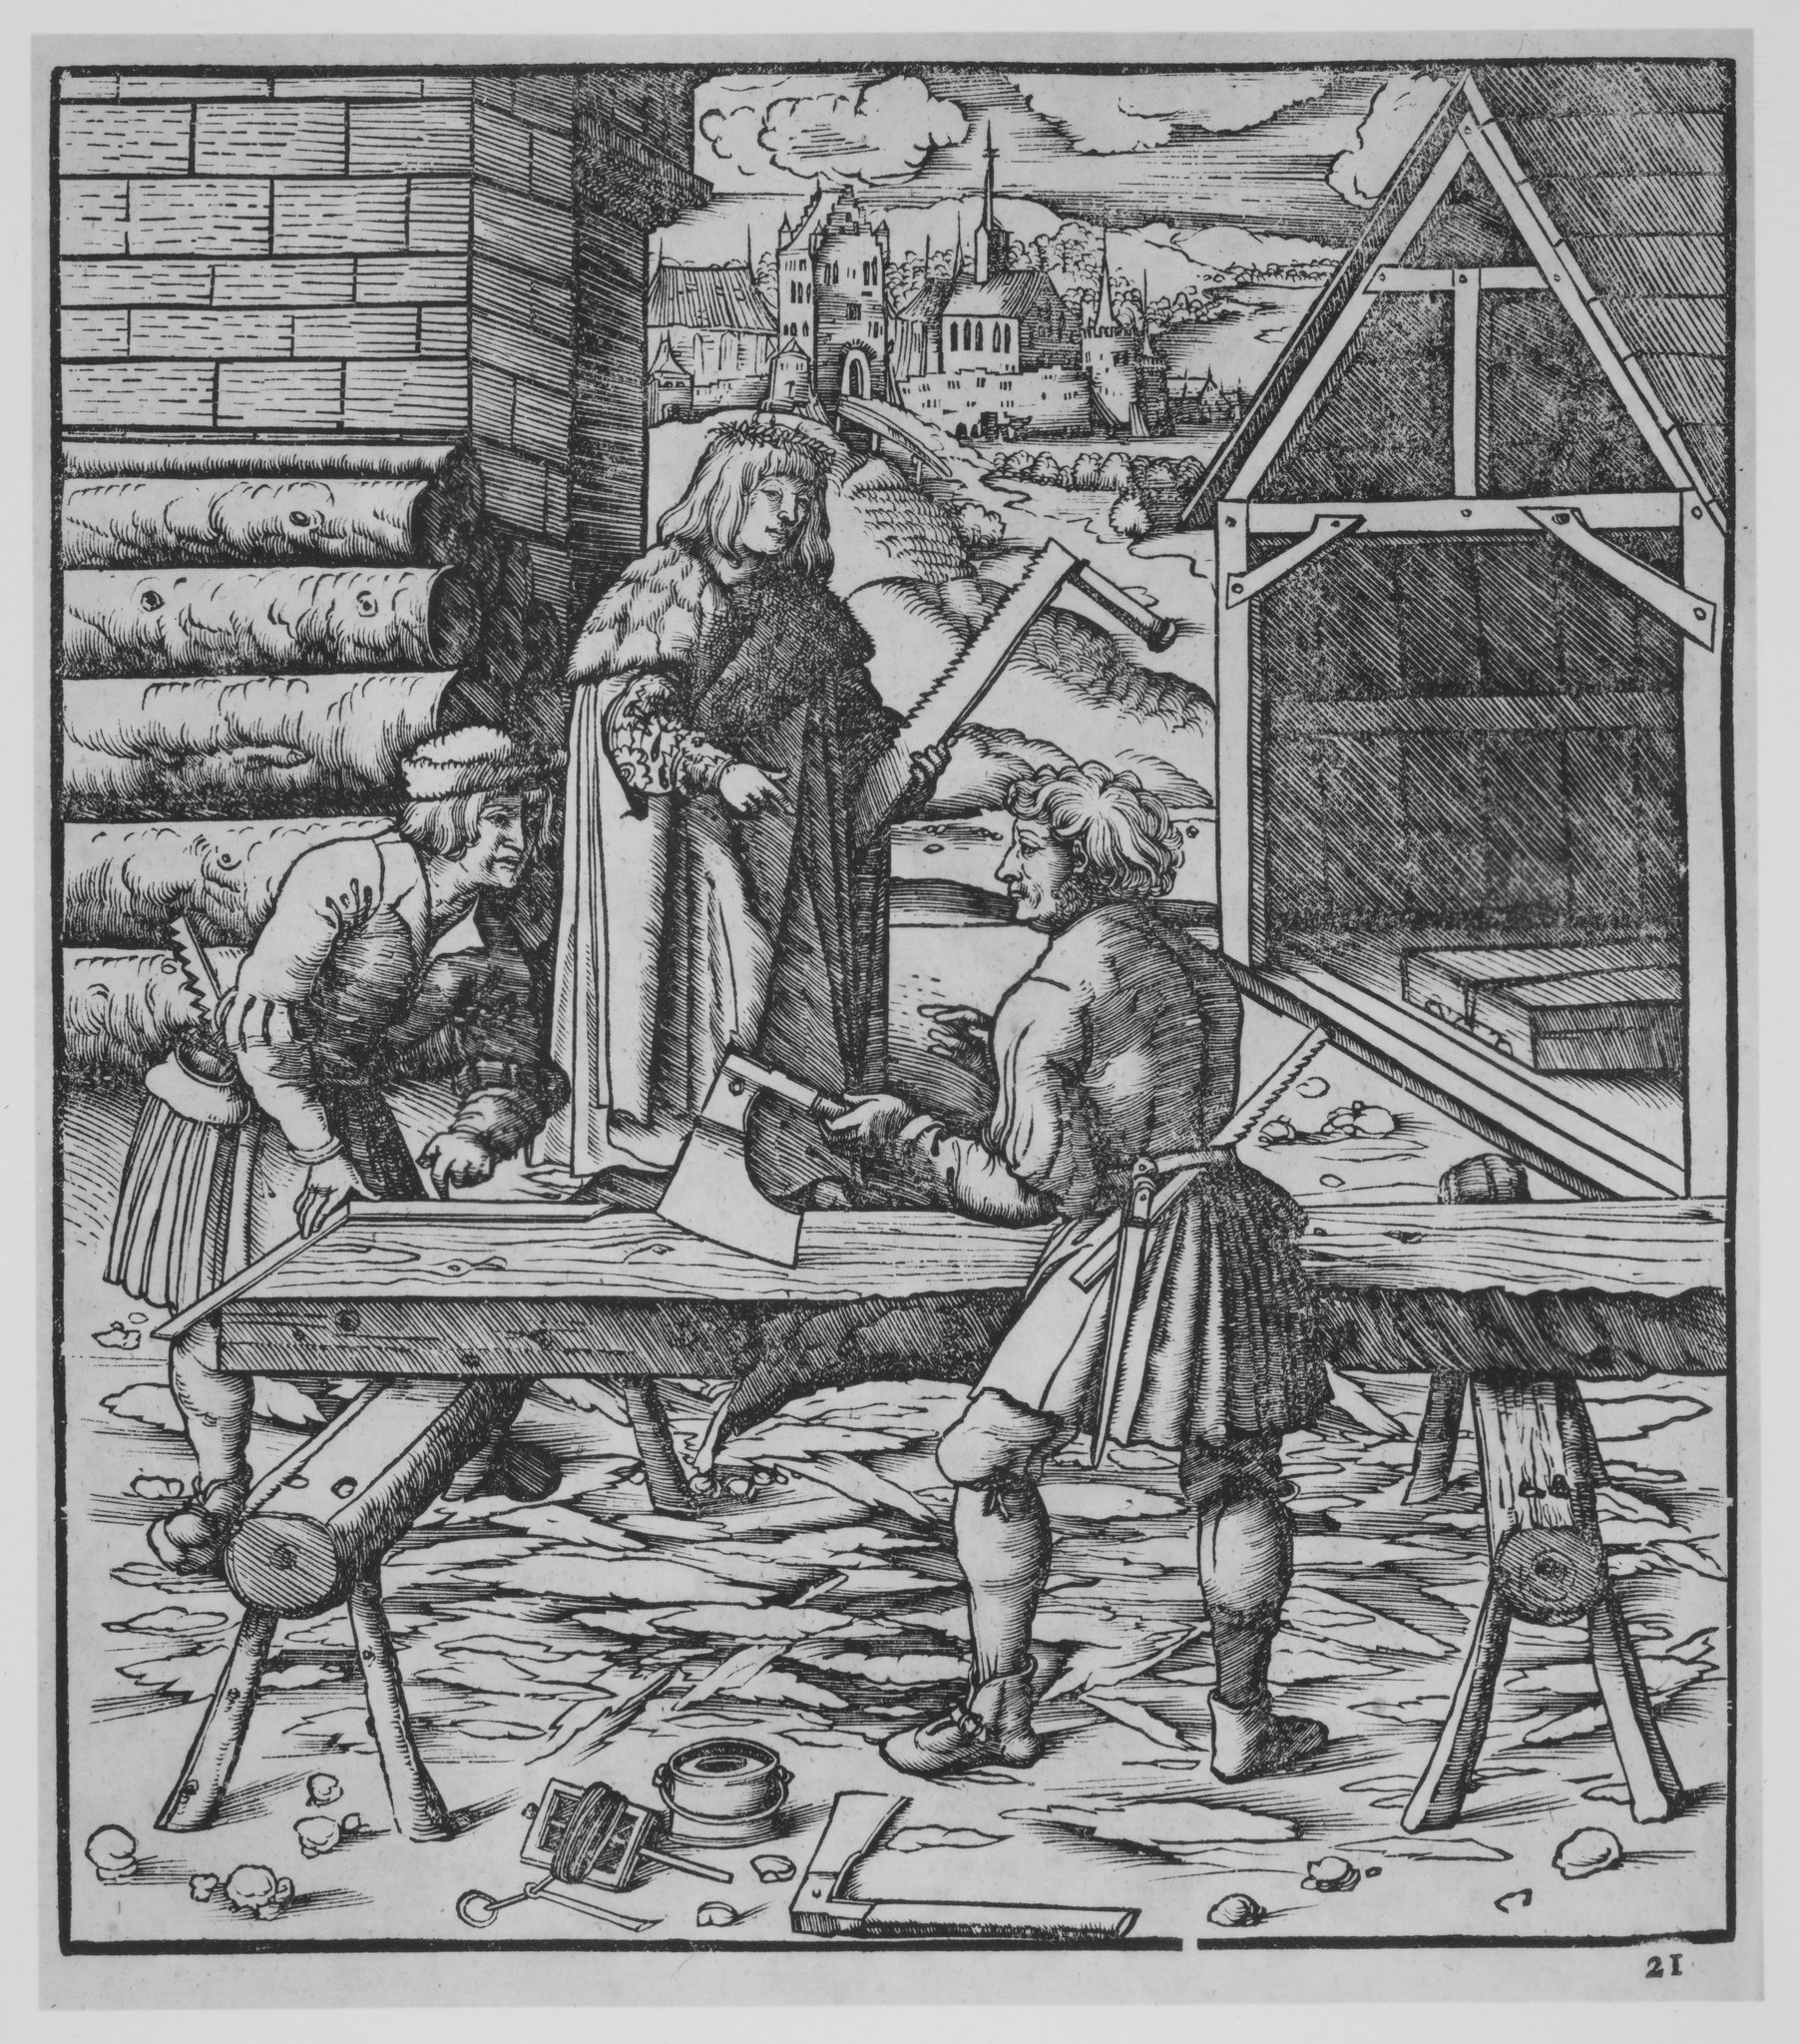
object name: book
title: Der Weiß Kunig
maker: hans burgkmair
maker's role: artist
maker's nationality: german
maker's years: 1473-1531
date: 1775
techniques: woodcut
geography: austria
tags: men,working